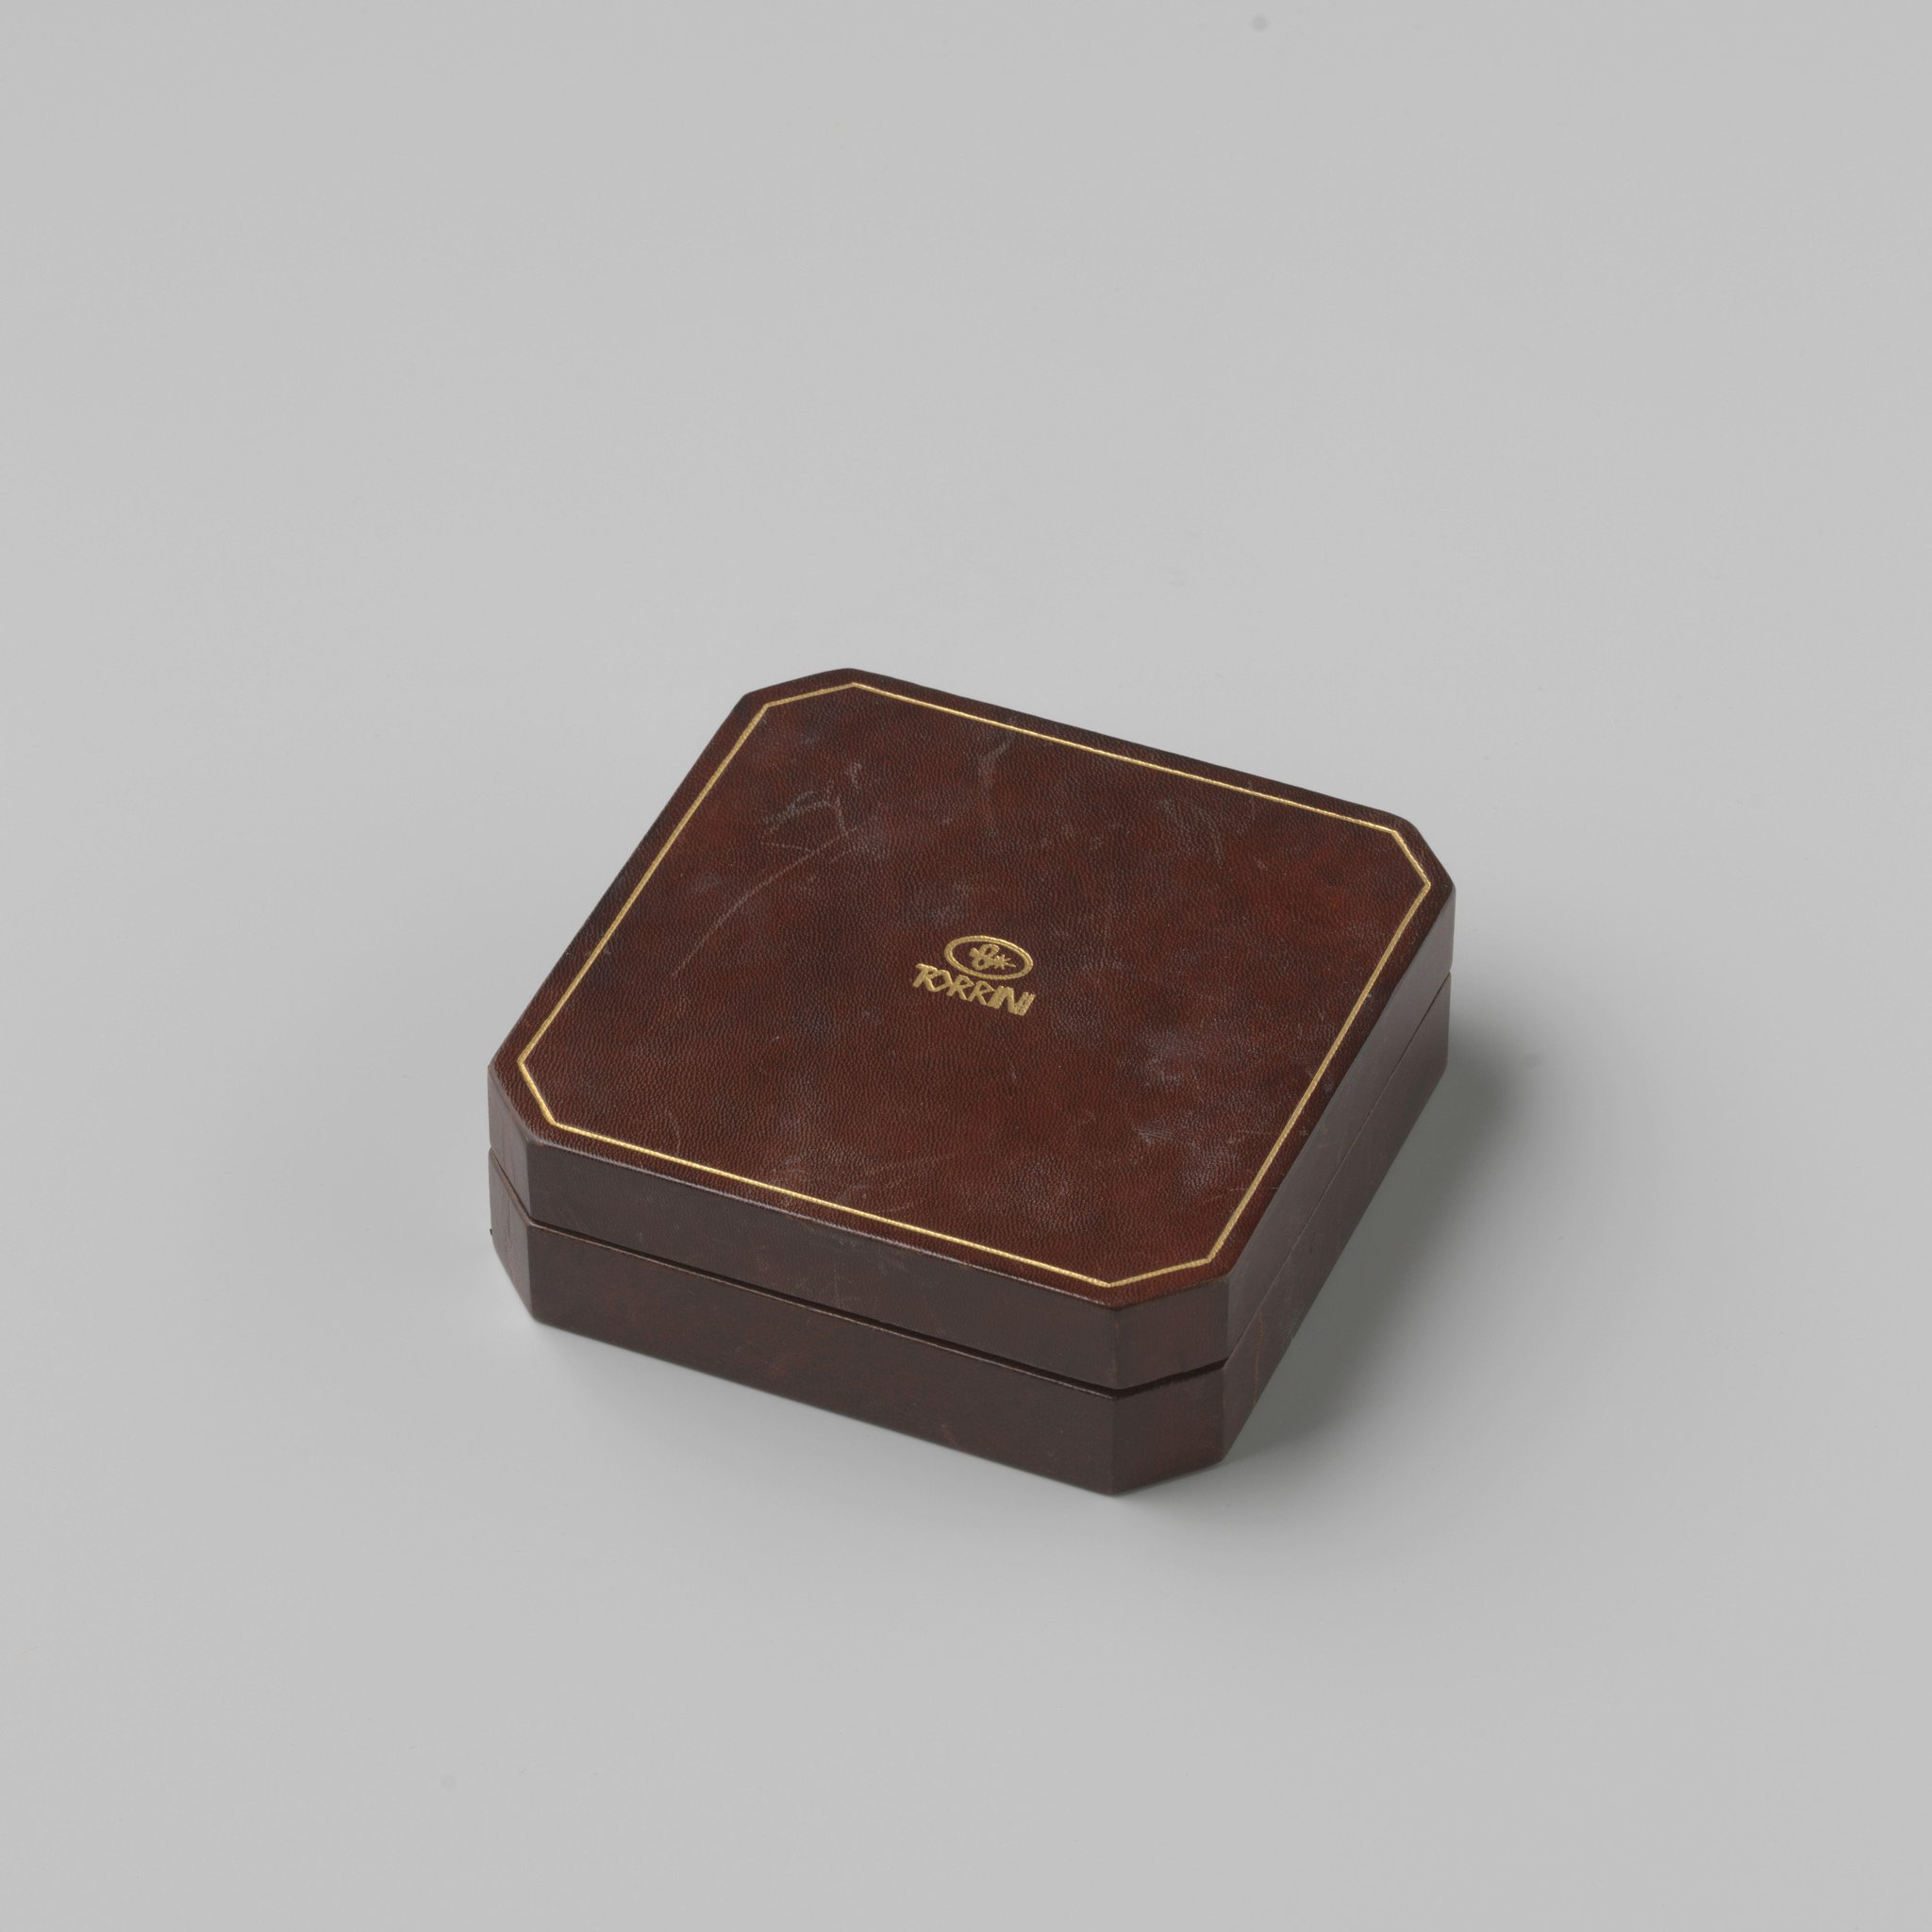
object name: medal box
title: Leren penningdoos bij penning van B'nai Berith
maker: Anonymous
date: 1912-1984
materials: leather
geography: amsterdam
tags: amsterdam, willem drees, netherlands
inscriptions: inscription: ‘TORRINI’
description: Bruin leren achthoekige penningdoos met op het dekel een gouden randje en in het midden een gouden merkje waaronder tekst. Binnenzijde van lichtbruin suède en uitsparing voor penning. In kartonnen doos.